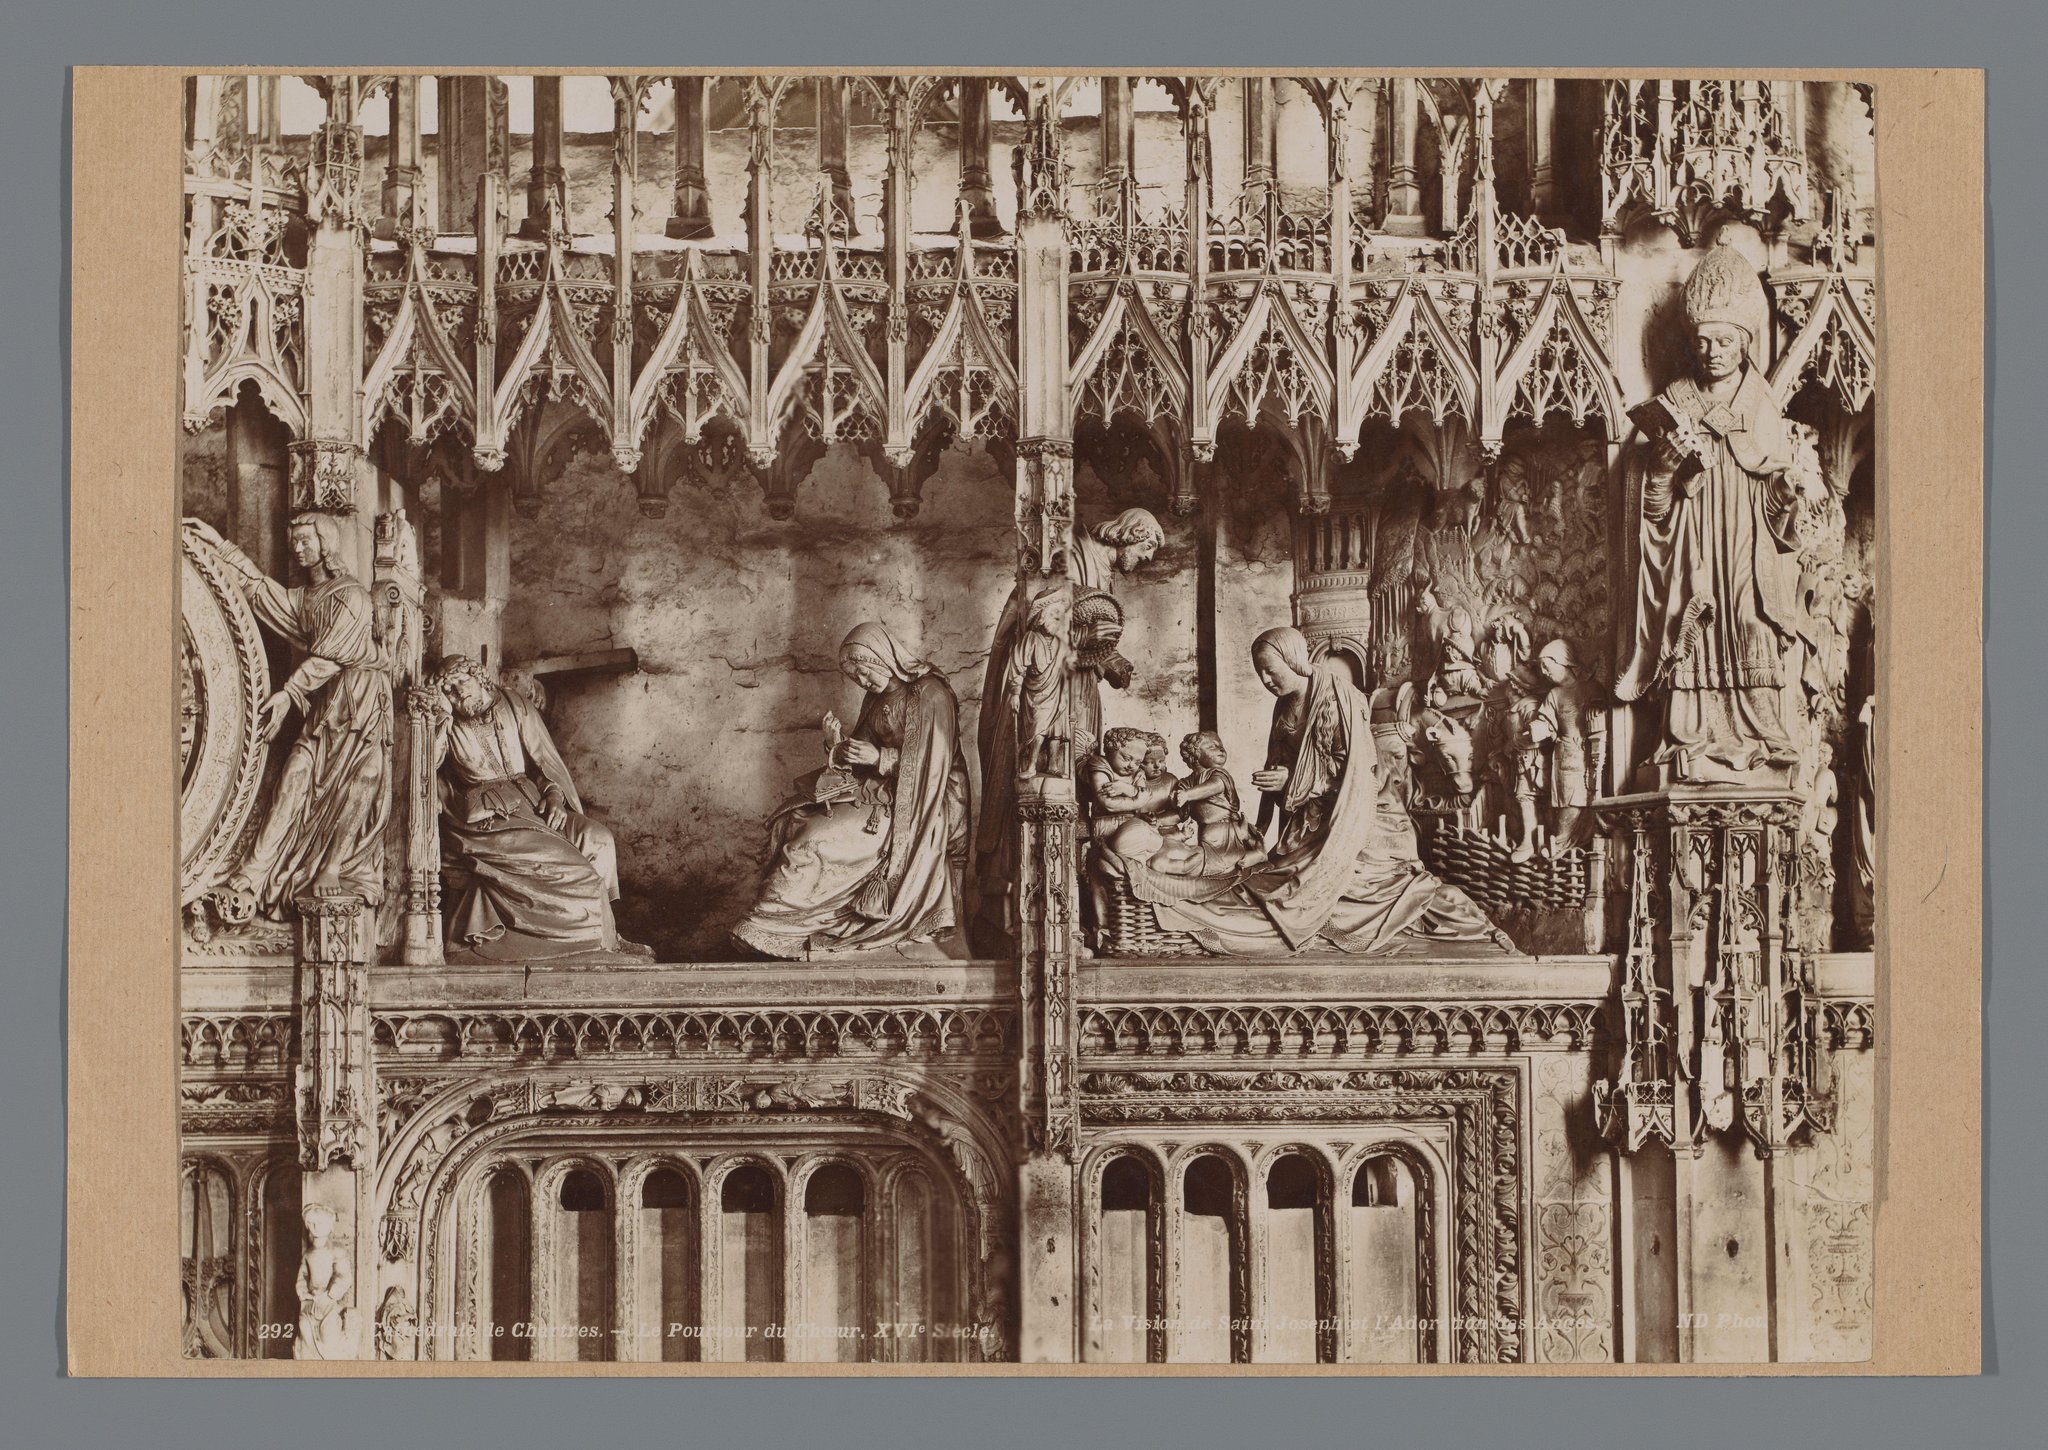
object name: photograph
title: Frankrijk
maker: Anonymous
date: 1870-1900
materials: photographic support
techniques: gelatin silver print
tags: france